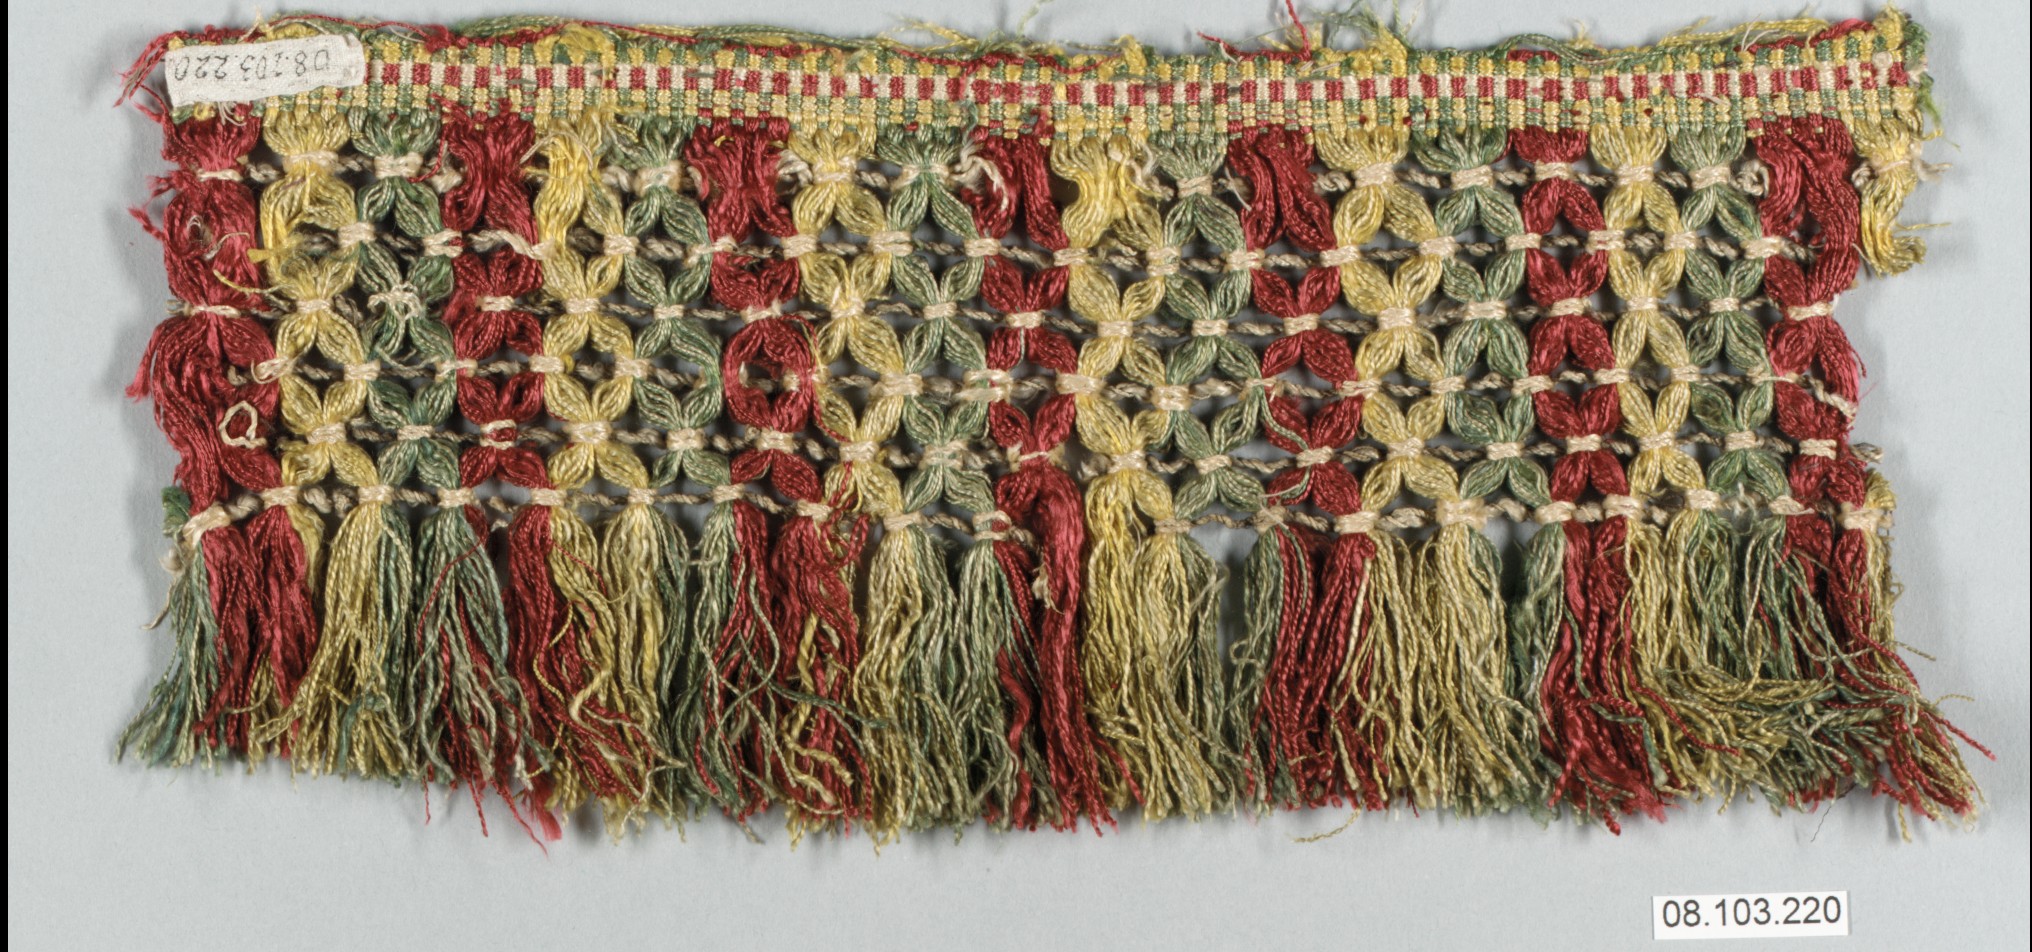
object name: fringe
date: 1601-1700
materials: silk